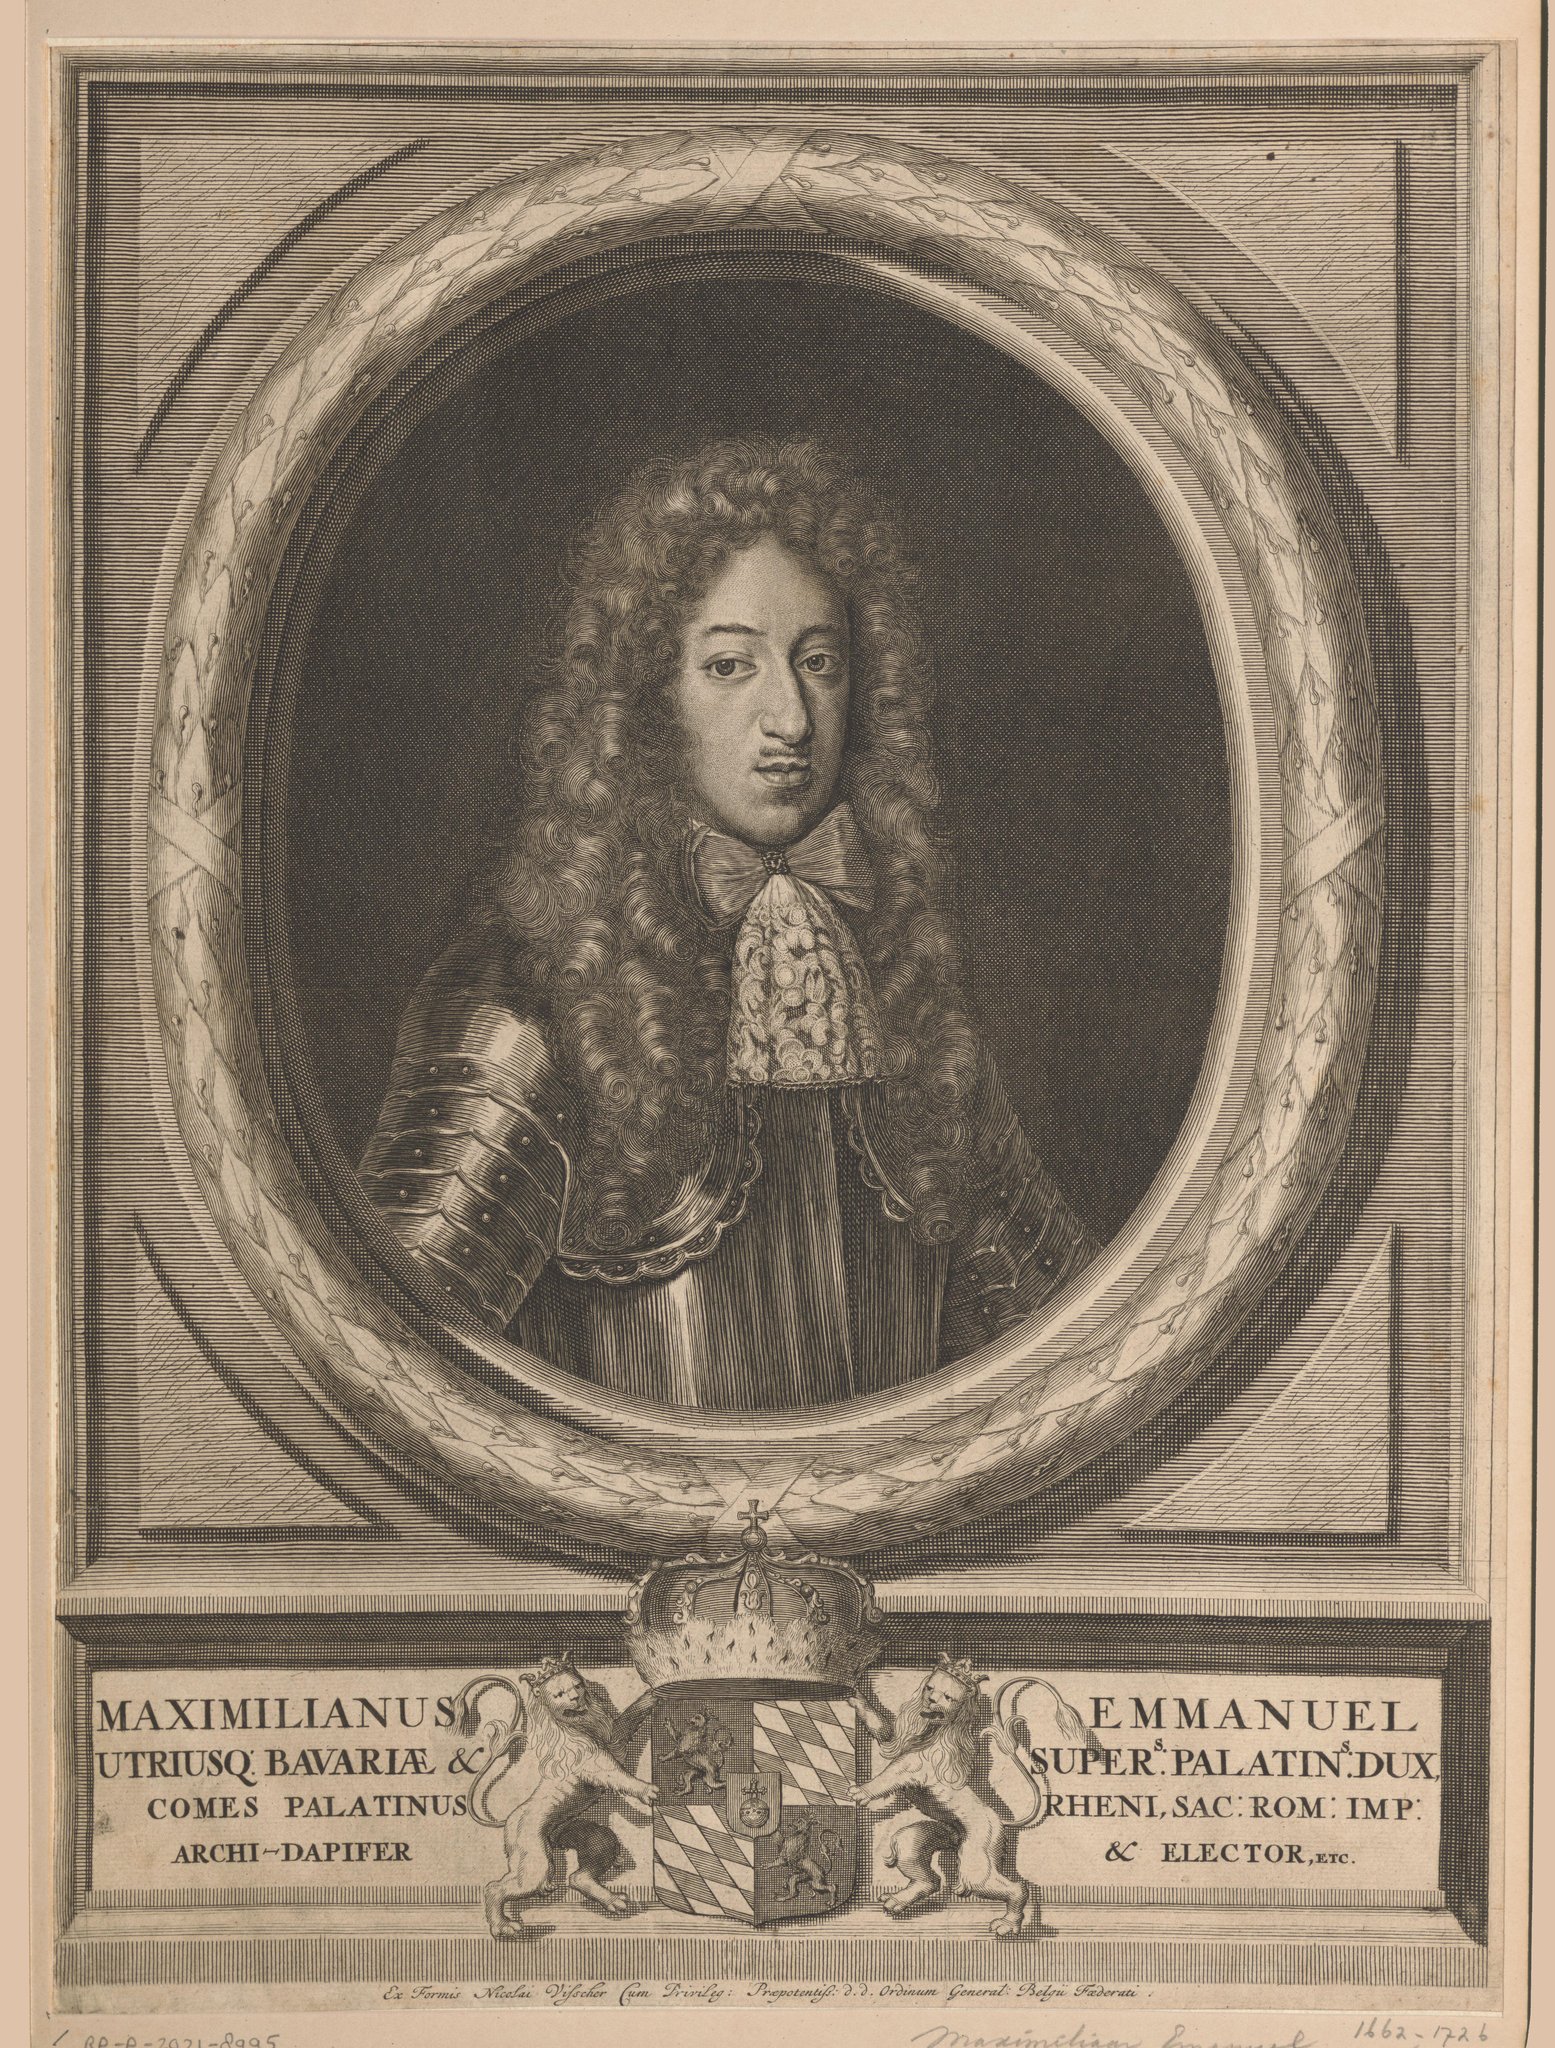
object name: print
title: Portret van Maximiliaan II Emanuel van Beieren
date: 1691-1702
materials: paper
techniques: engraving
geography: amsterdam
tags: maximiliaan ii emanuel (keurvorst van beieren), ornament ~ medallion, armour, historical persons, armorial bearing, heraldry